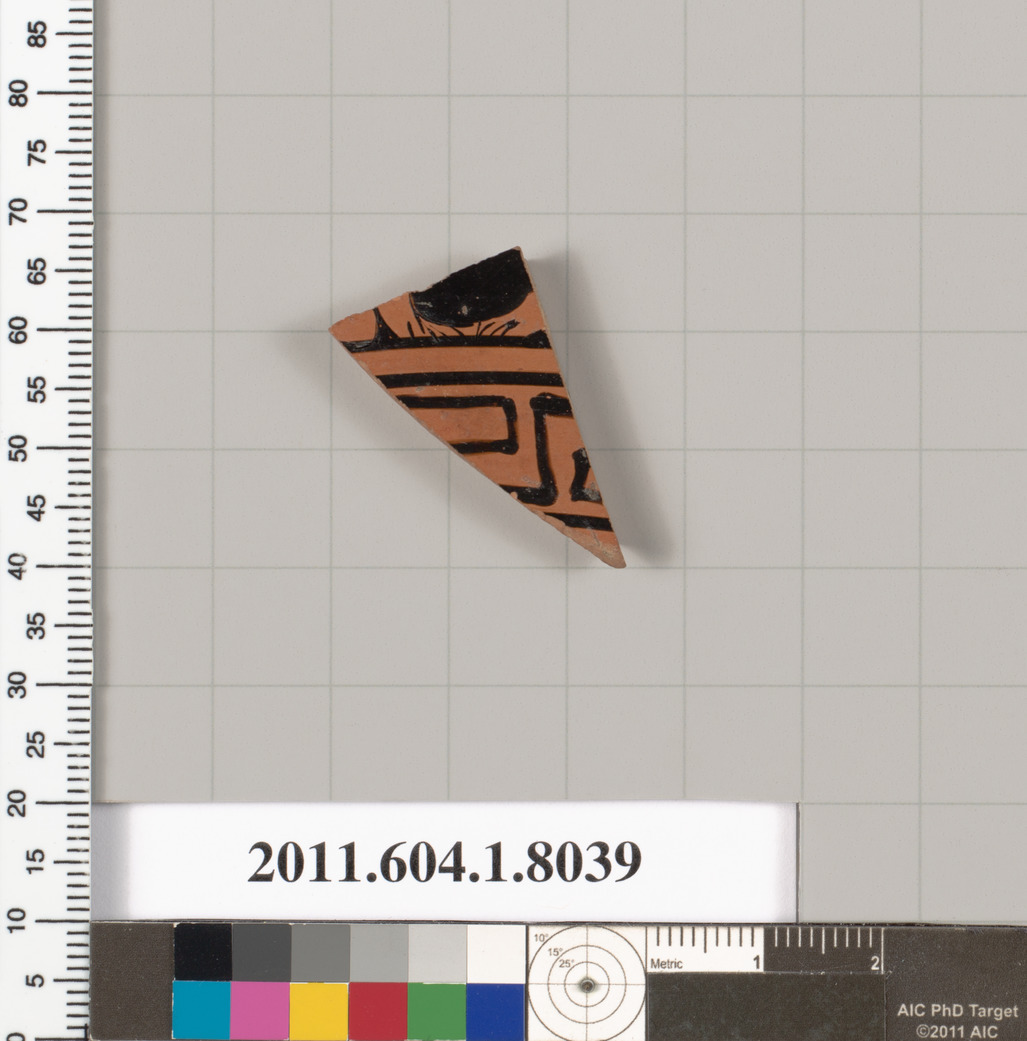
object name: kylix fragment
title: Terracotta fragment of a kylix (drinking cup)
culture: greek, attic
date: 500-480 BCE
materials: terracotta